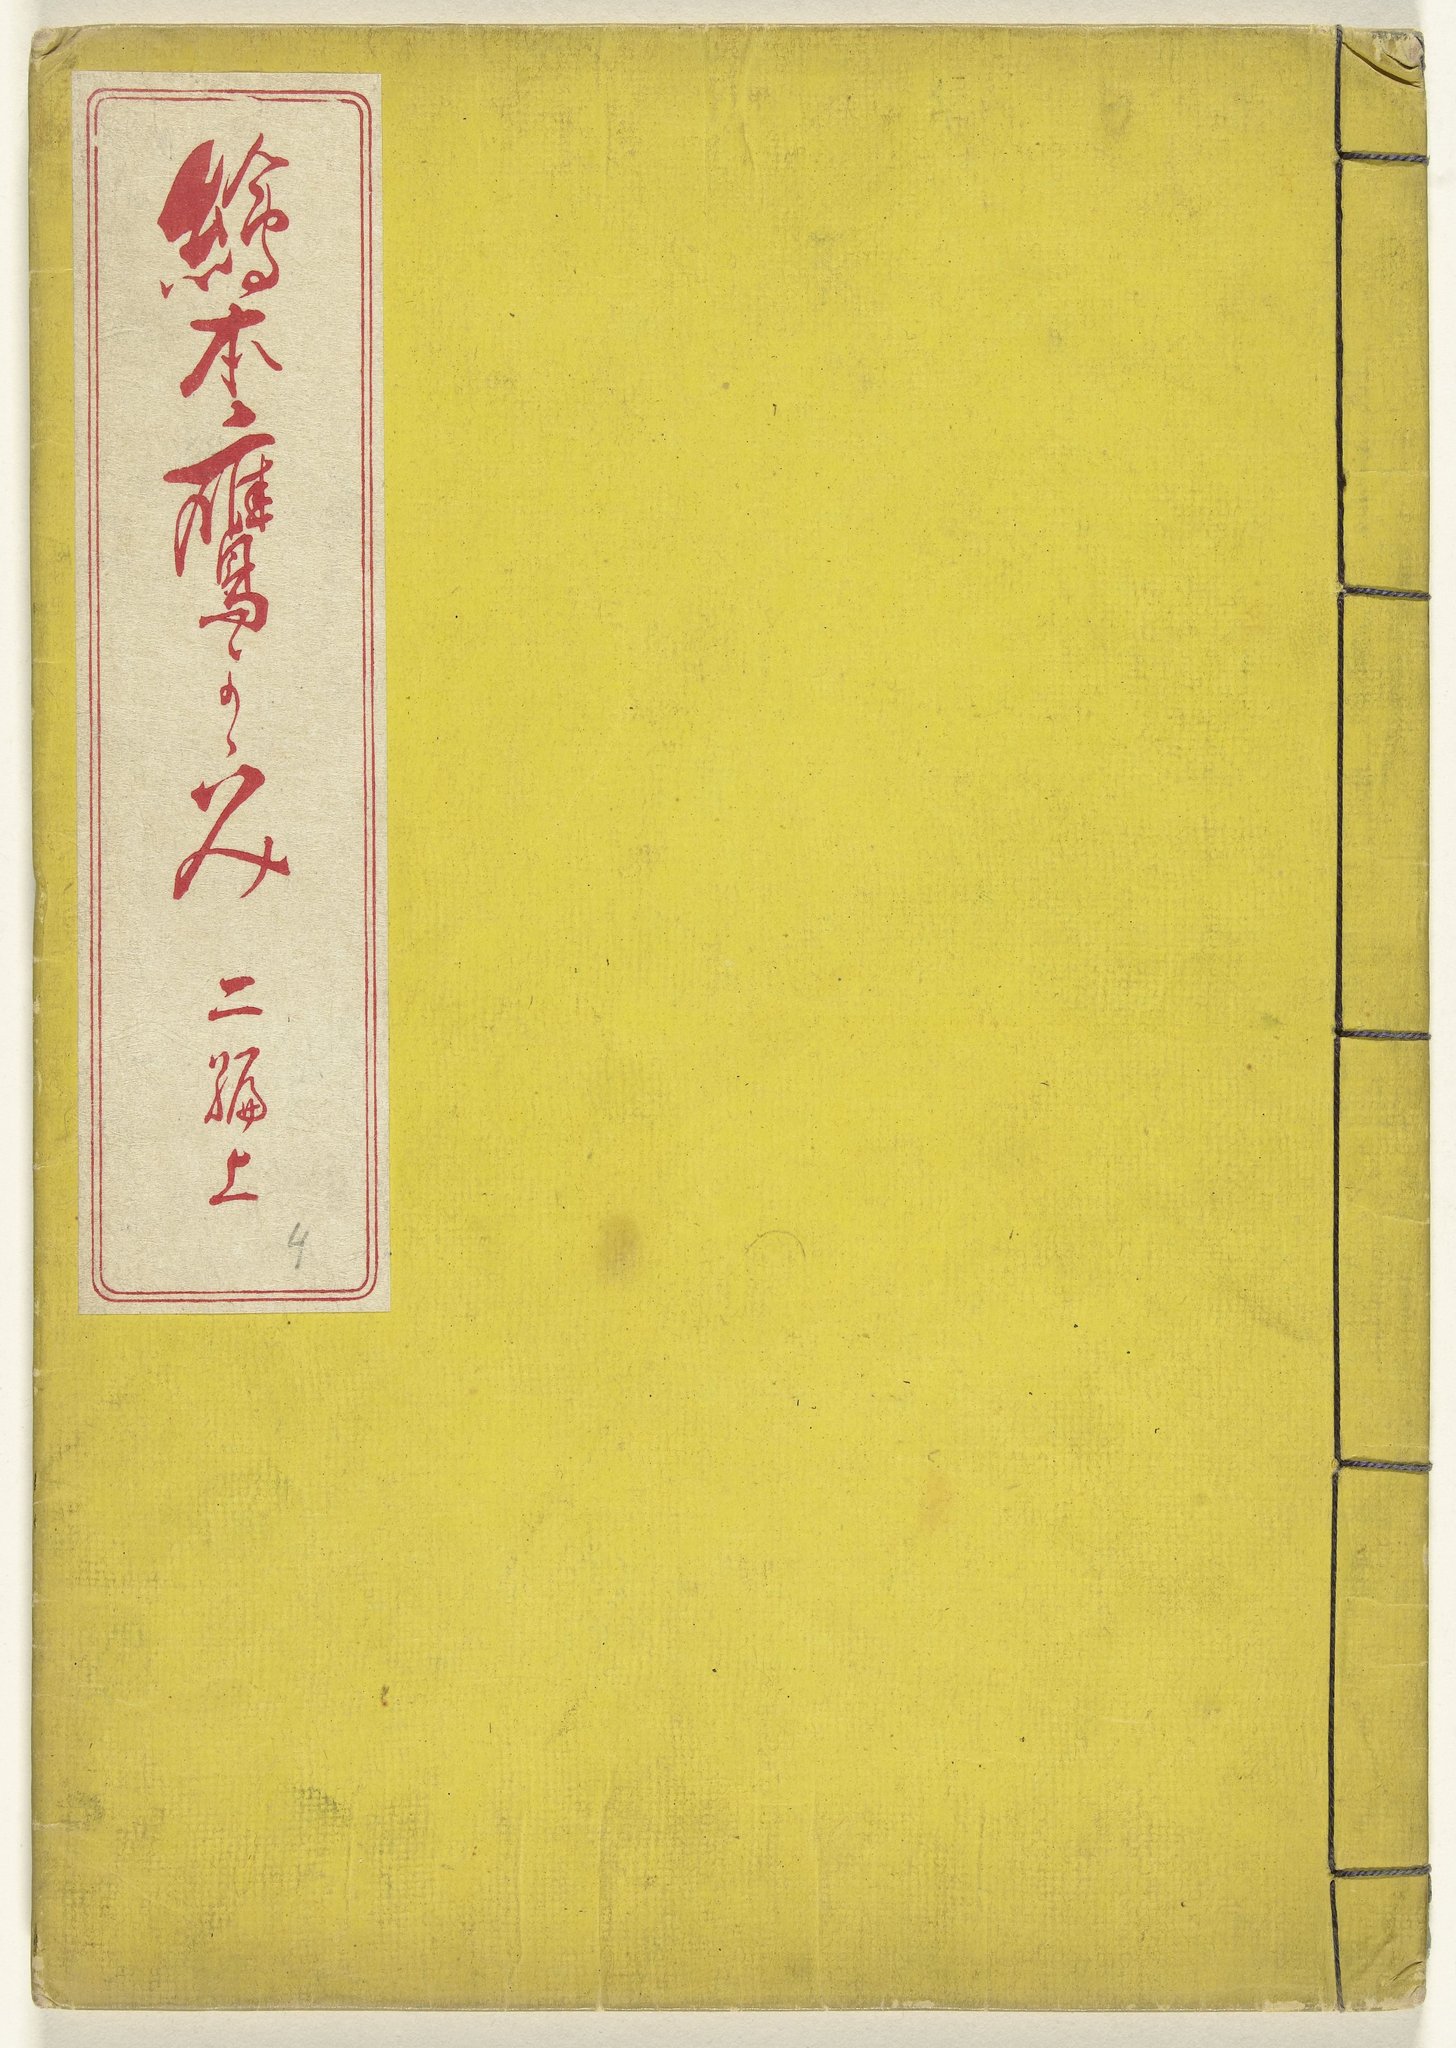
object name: book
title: Ehon taka kagami - nihen jo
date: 1877-1879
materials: paper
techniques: woodcut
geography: tokyo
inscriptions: collector's mark: Lugt 2228